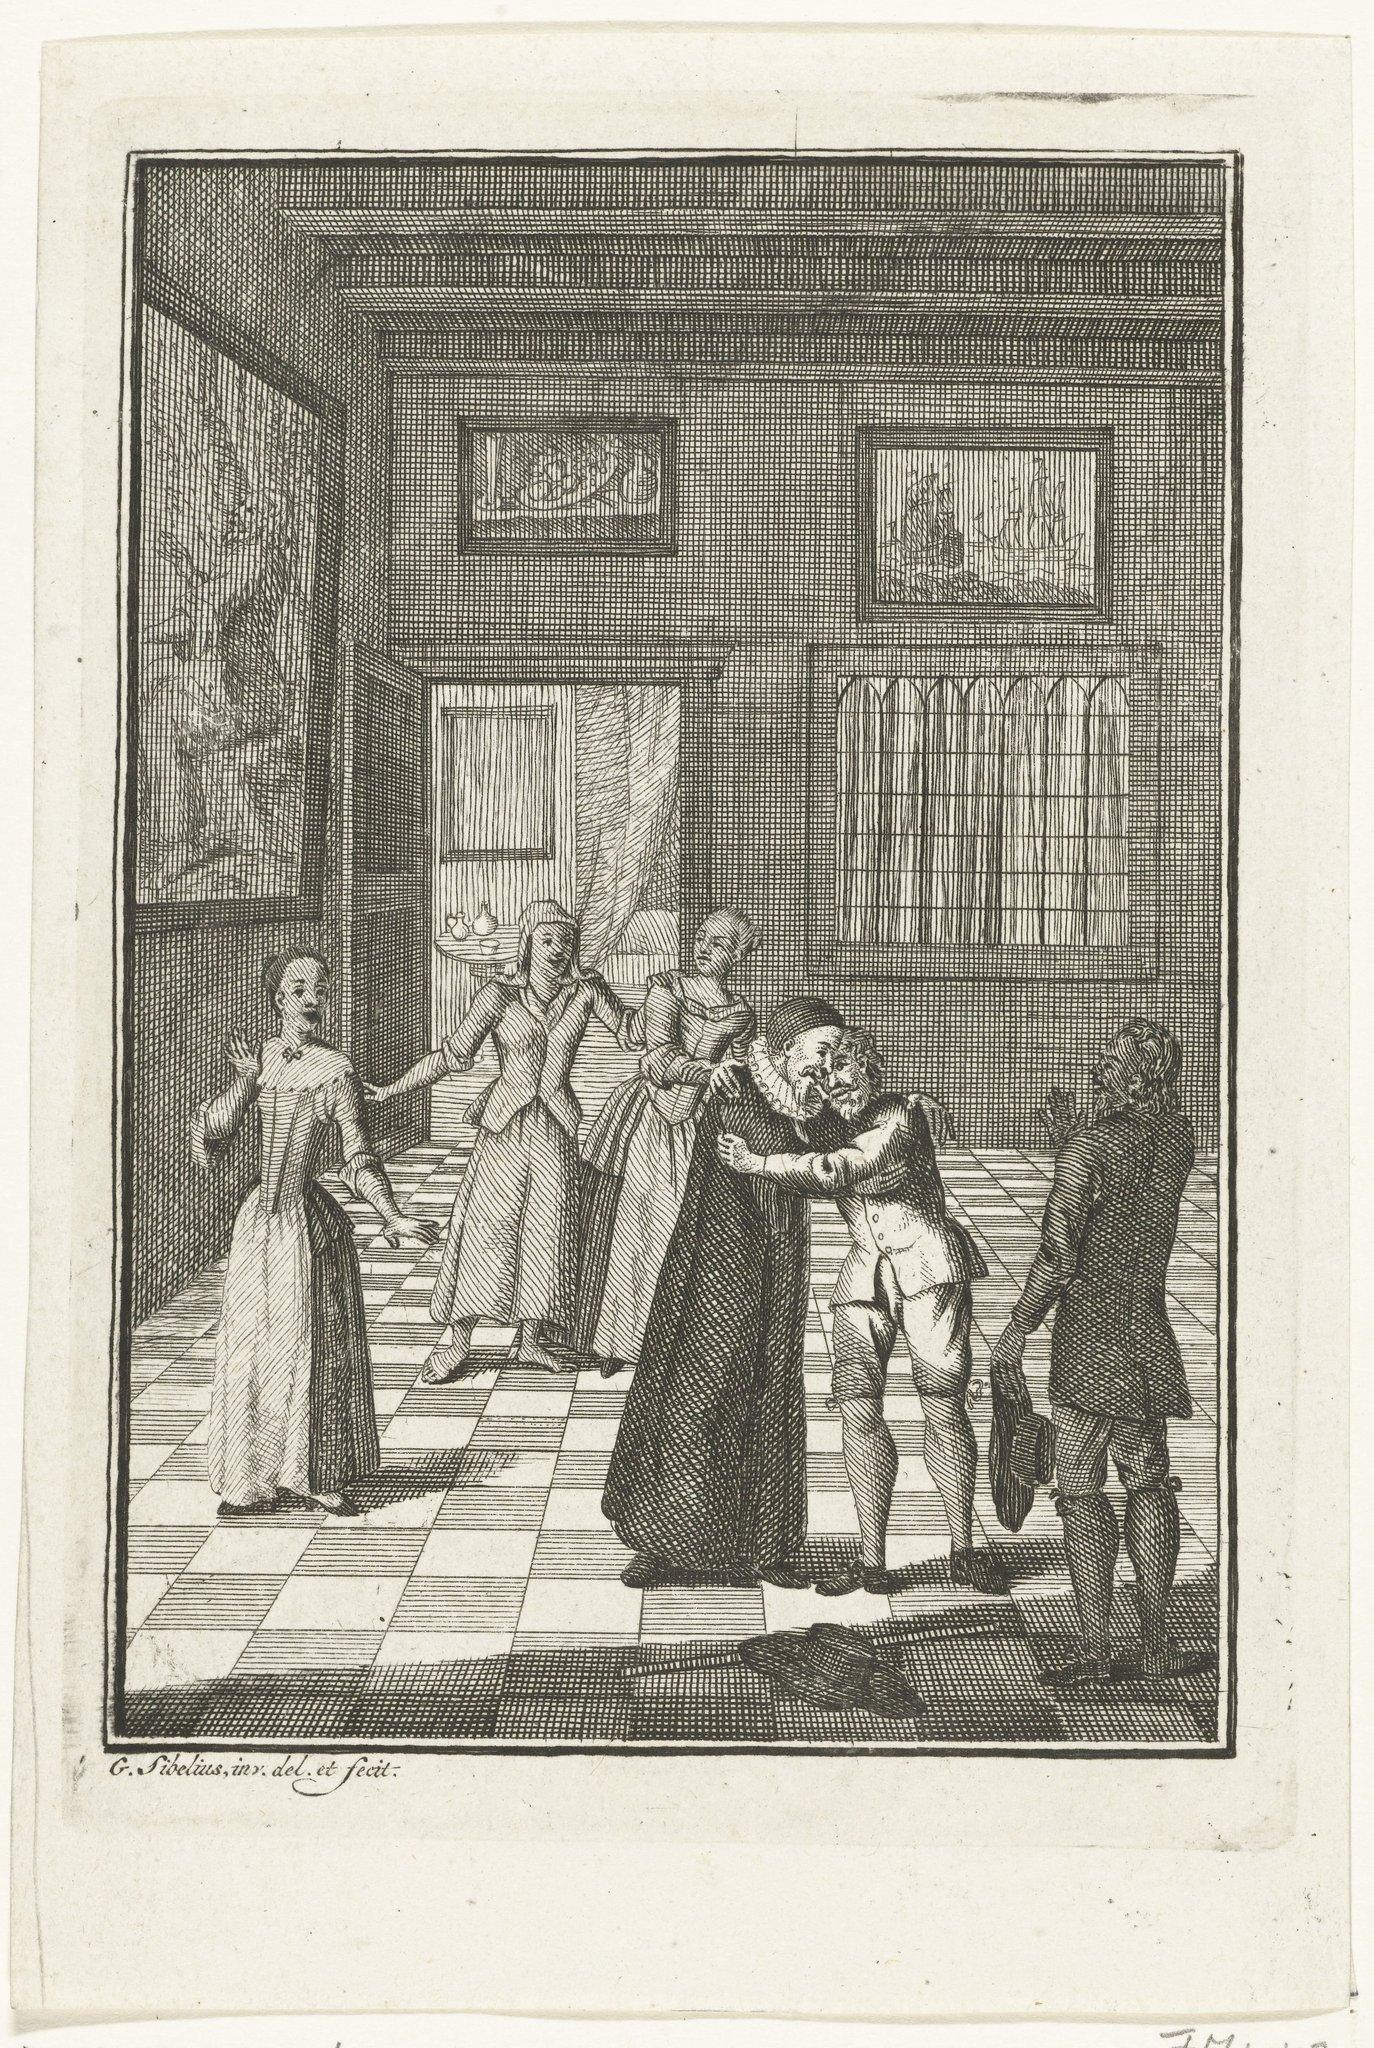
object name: history print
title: Hugo de Groot wordt in Antwerpen ontvangen door Grevinkhoven, 1621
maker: gerard sibelius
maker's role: print maker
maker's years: 1734-1785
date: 1768-1771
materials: paper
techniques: engraving, etching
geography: northern netherlands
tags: delft, hugo de groot, rotterdam, antwerp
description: Hugo de Groot wordt na zijn ontsnapping uit Loevestein in Antwerpen ontvangen door de gewezen Rotterdamse predikant Nicolaas Grevinkhoven, 23 maart 1621.